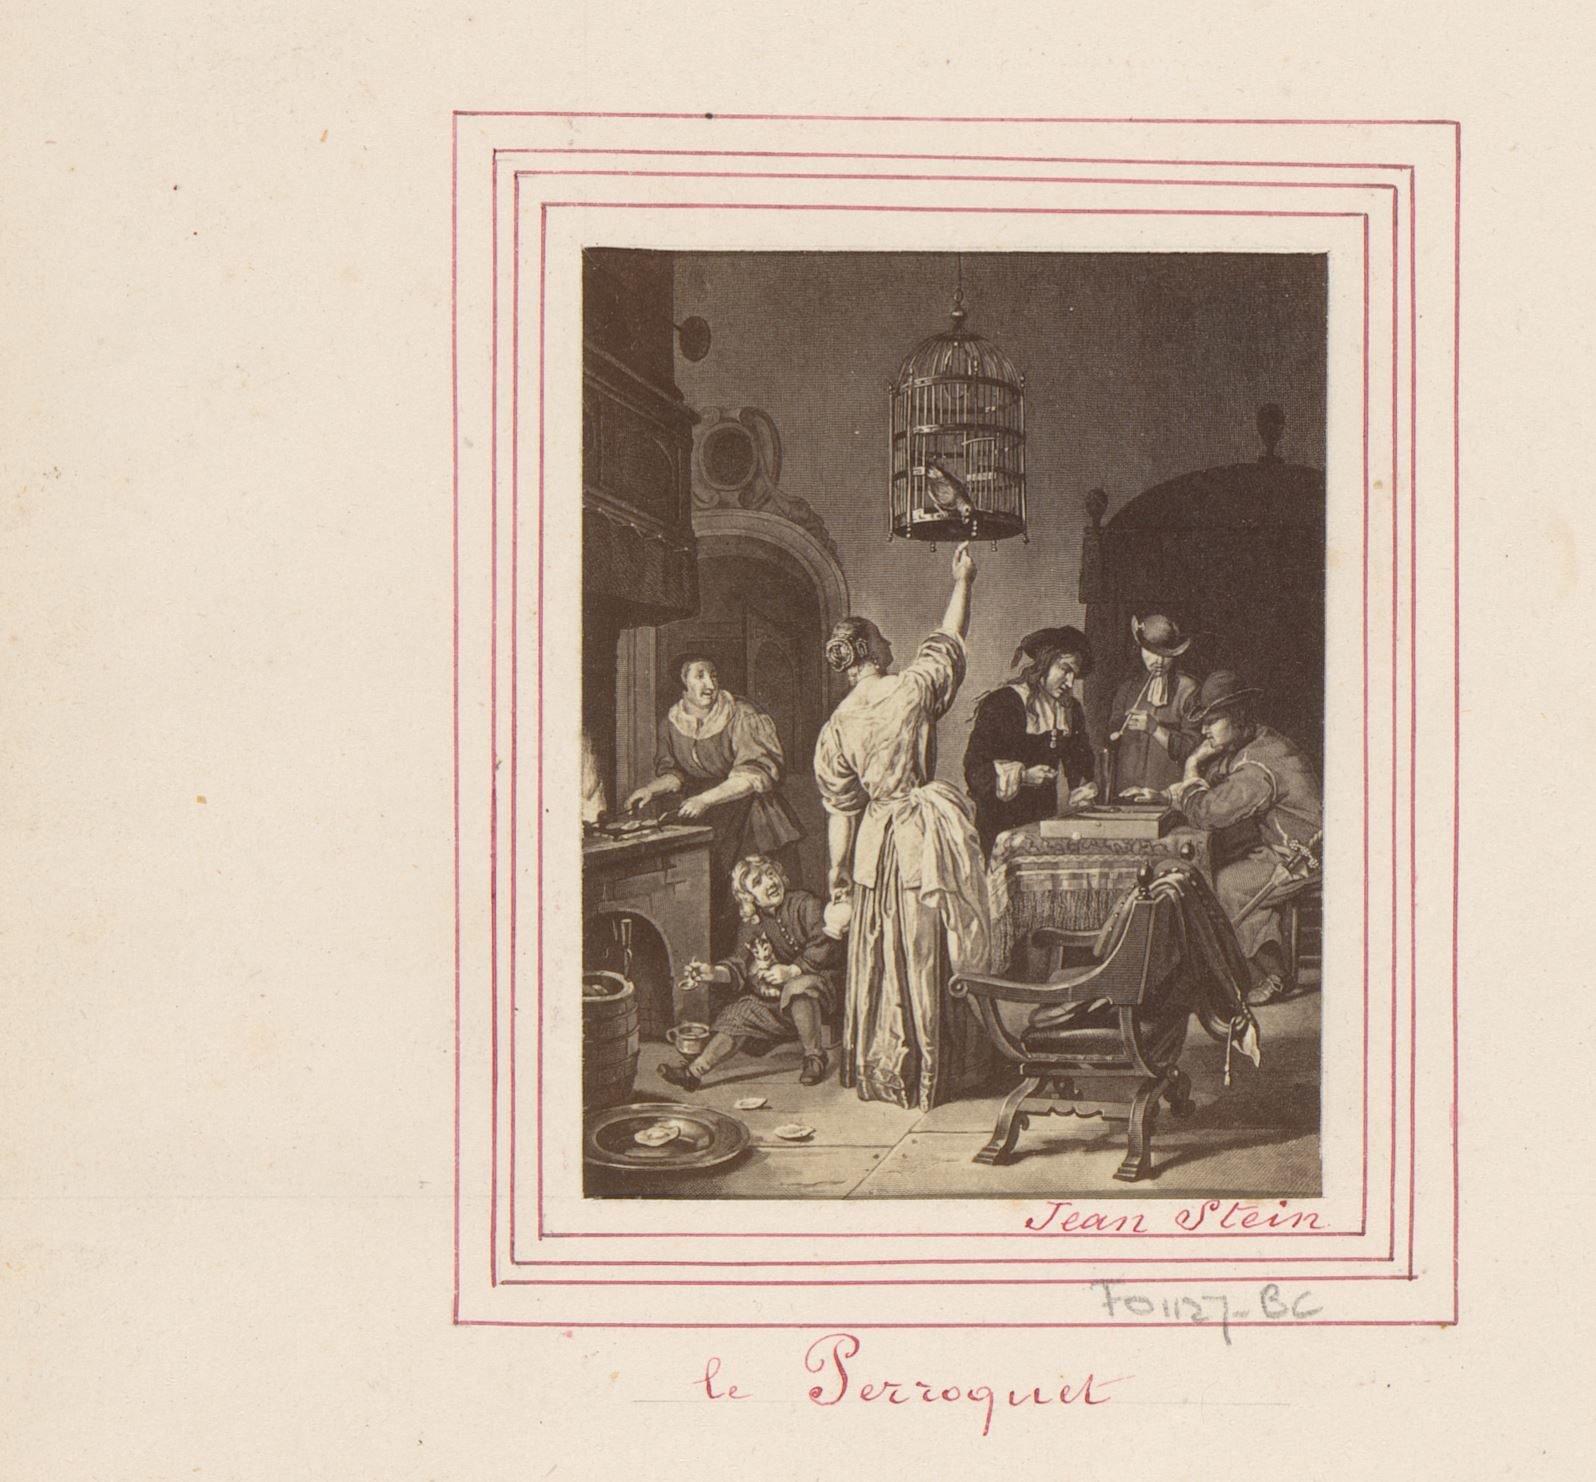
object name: reproduction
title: Fotoreproductie van een prent naar het schilderij Interieur met een vrouw, die een papegaai voert, twee triktrakspelers en andere figuren, bekend als 'De papegaaiekooi' door Jan Steen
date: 1865-1875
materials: photographic support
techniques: albumen print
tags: bird in a cage (+ feeding animal), ornamental birds: parrot, backgammon, tric-trac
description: Onderdeel van Album met foto's en litho's van bezienswaardigheden in Noord- en Zuid-Hollandse steden, schilderijen en klederdrachten.